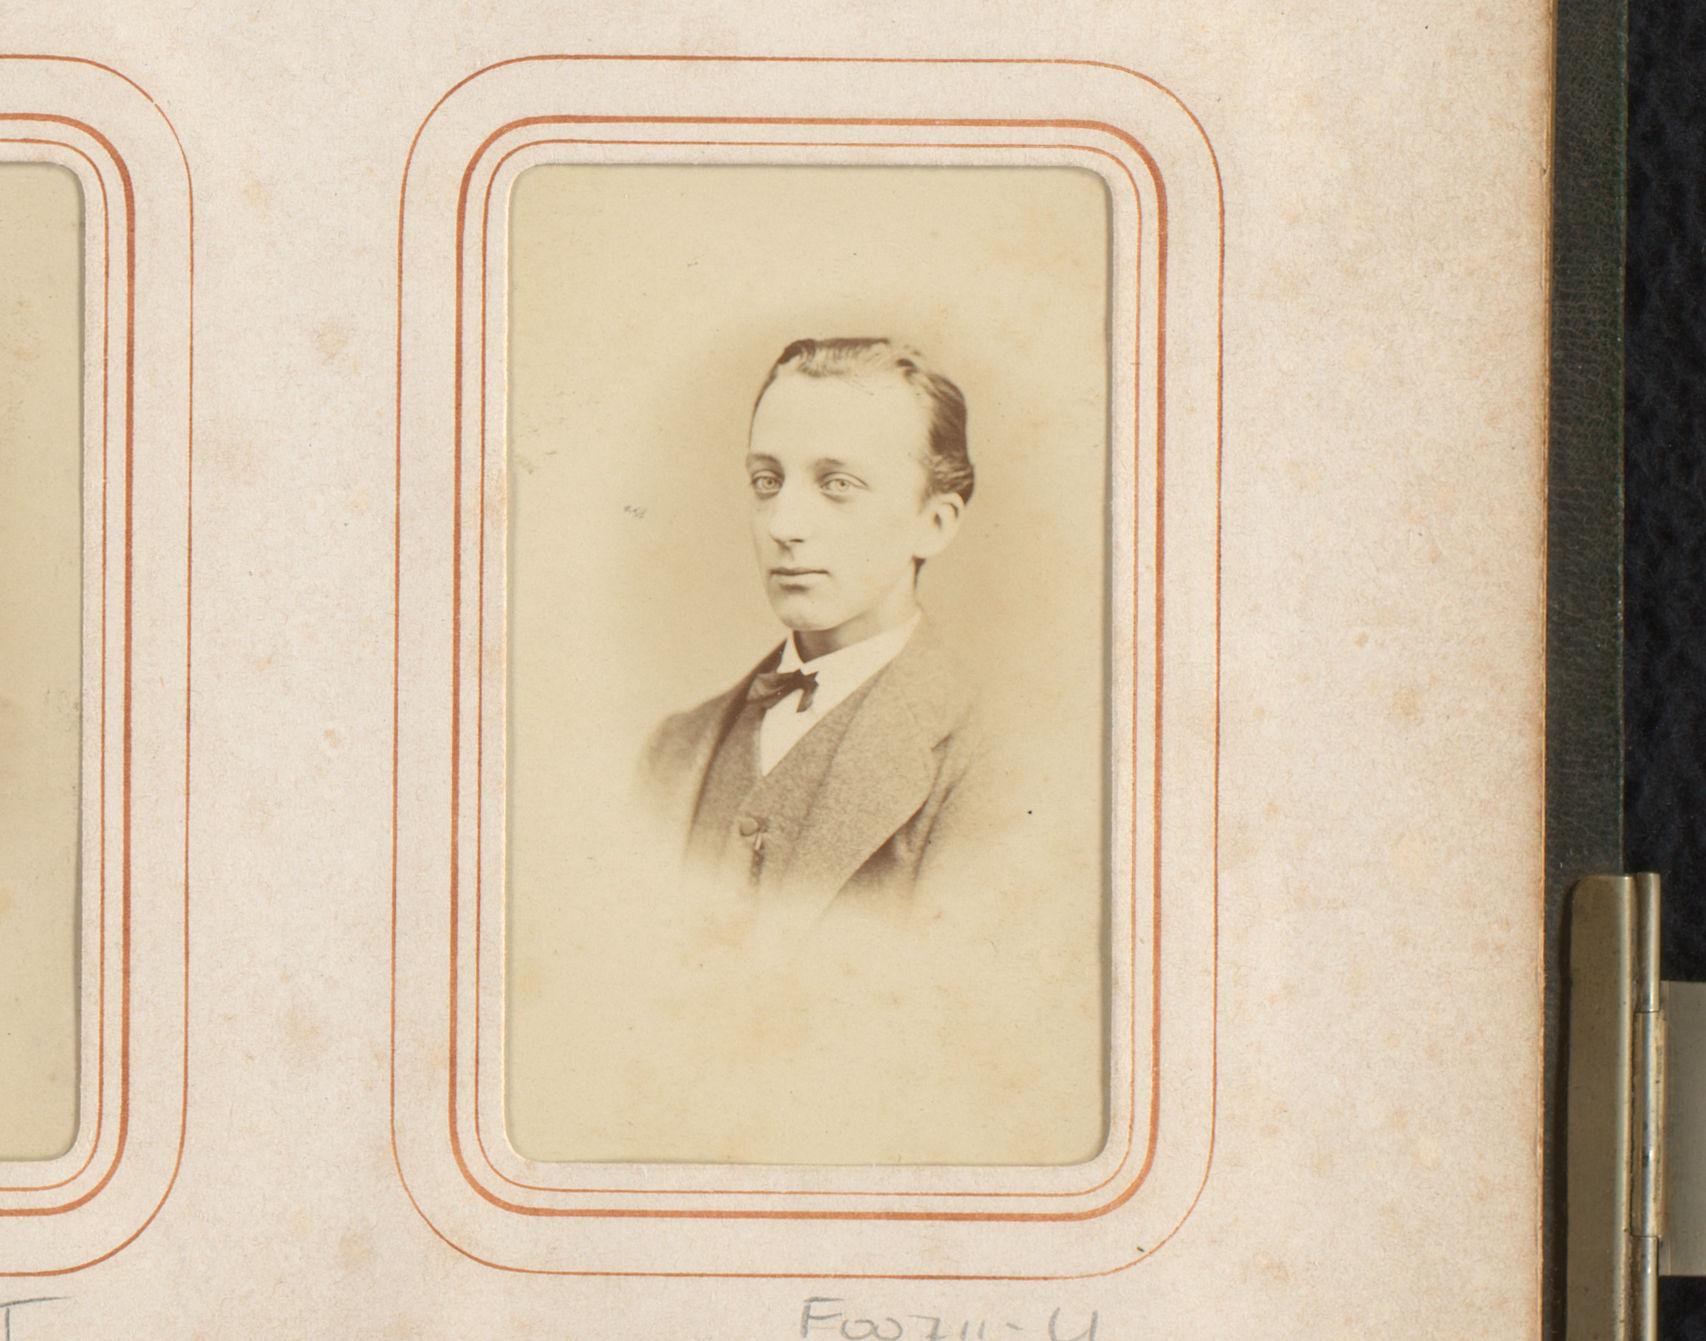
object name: photograph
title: Portret van een jongeman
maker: albert greiner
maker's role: fotograaf, fotostudio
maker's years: 1833-1890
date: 1861-1874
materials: cardboard, photographic support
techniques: albumen print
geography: amsterdam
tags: youth, adolescent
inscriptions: inscription: ‘A. Greiner/ Photograf/ Nieuwendijk L.87/ Amsterdam’